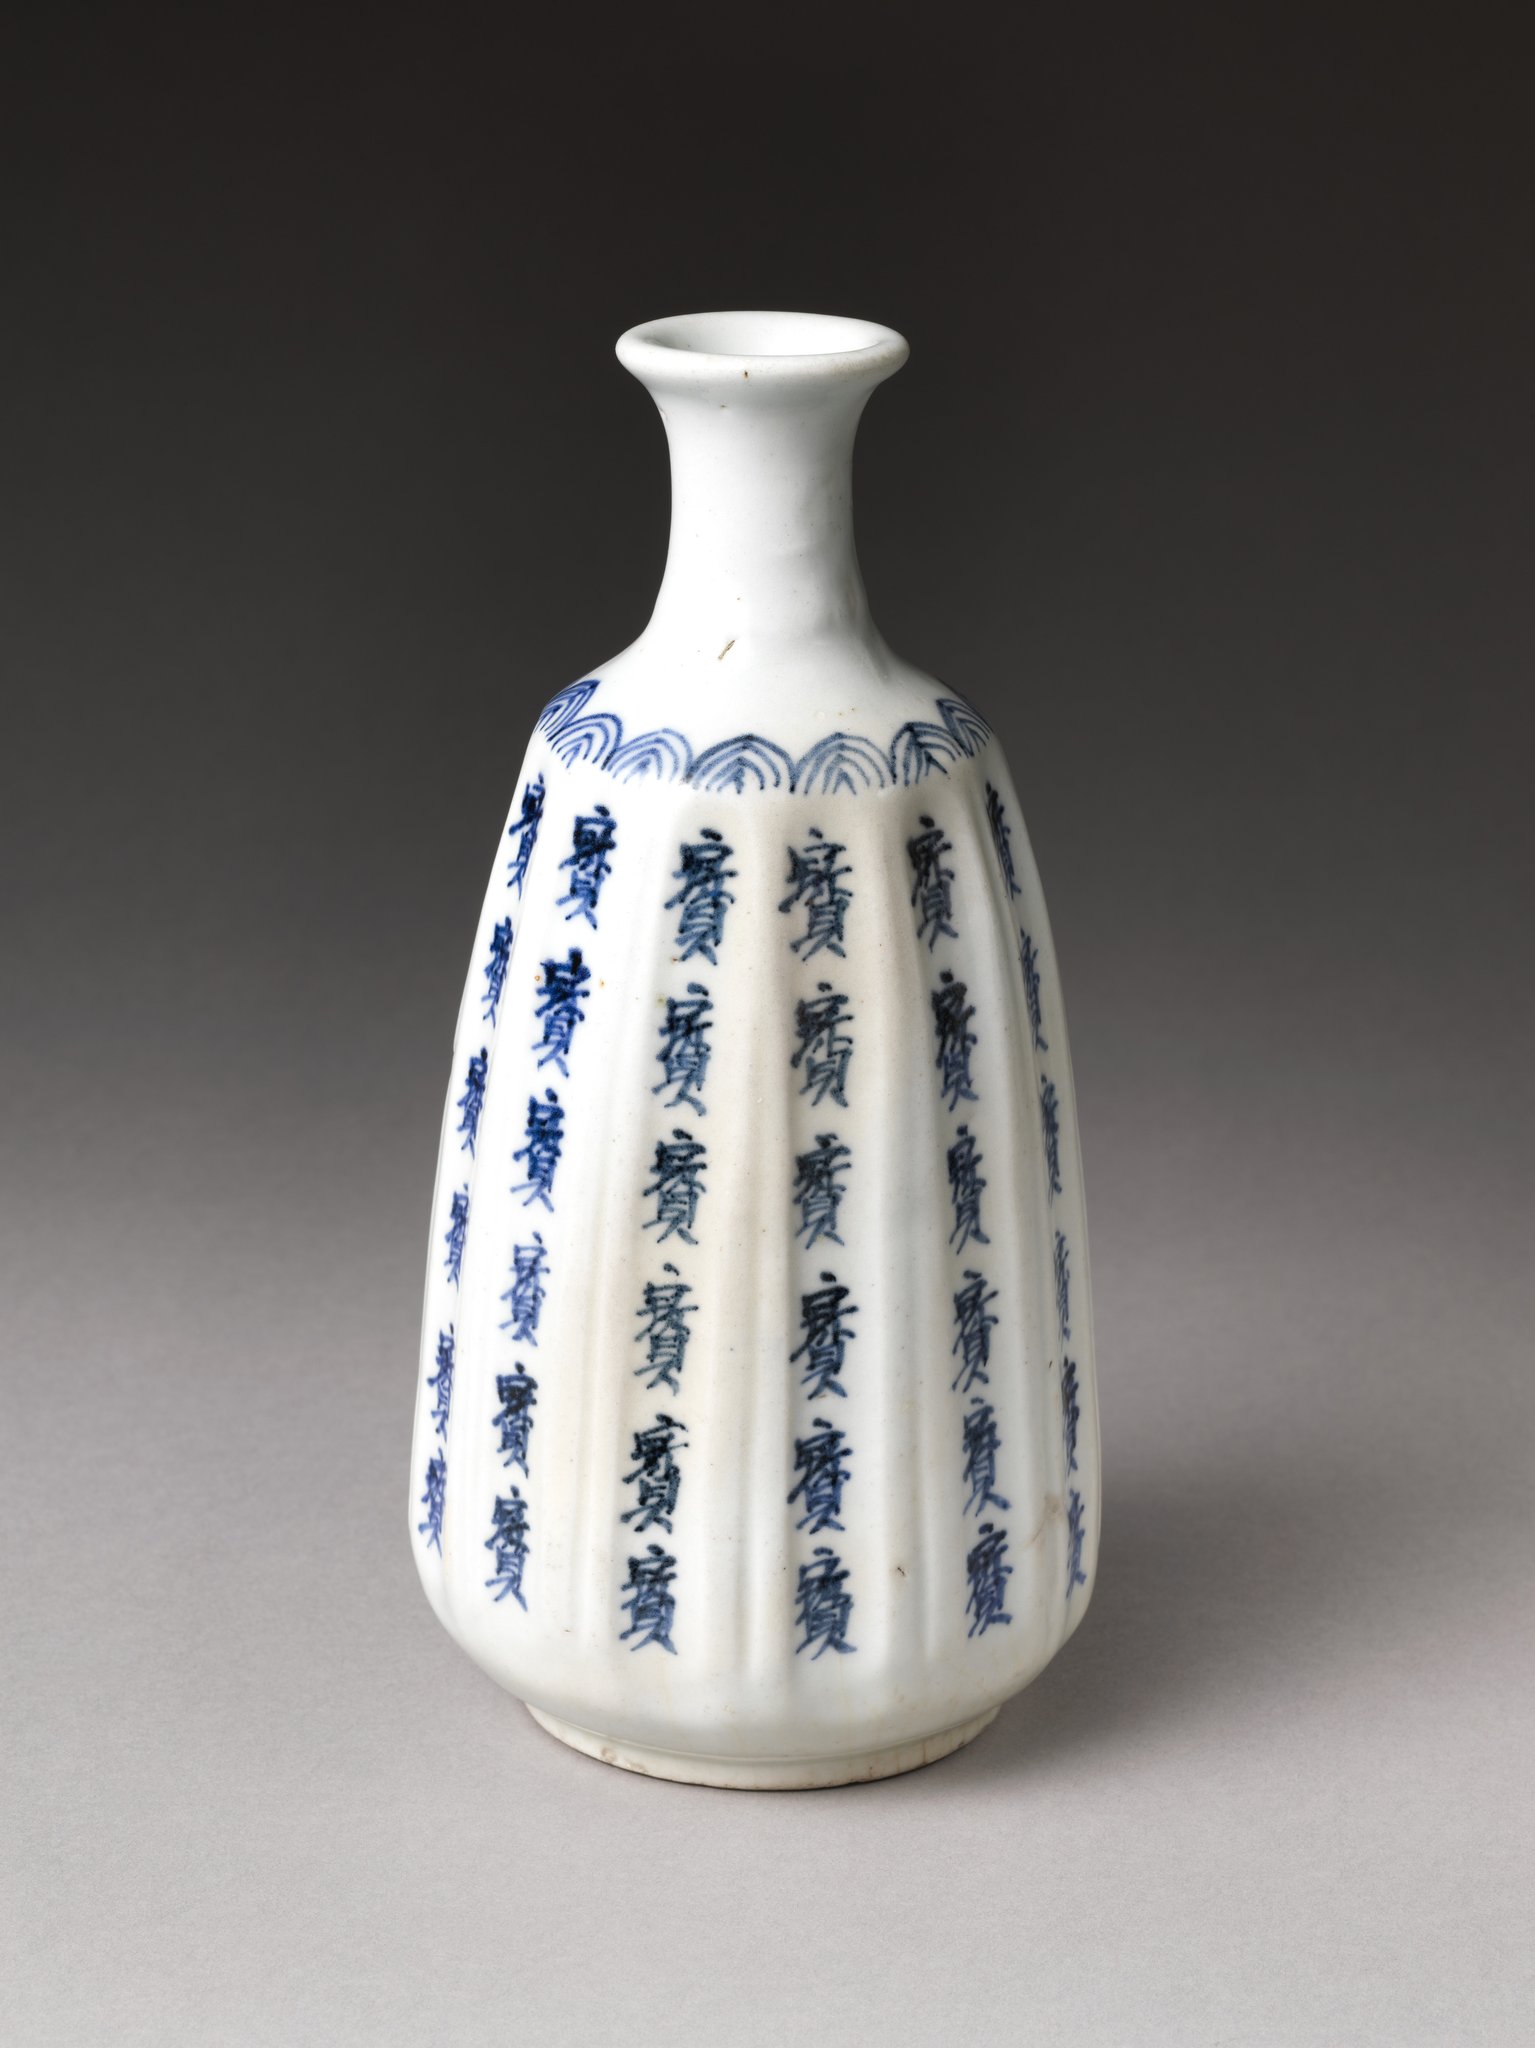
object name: wine bottle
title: Wine Bottle with Chinese Character Reading Treasure (Japanese, takara)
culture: japanese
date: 1667-1700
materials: cobalt, glaze, porcelain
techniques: painting